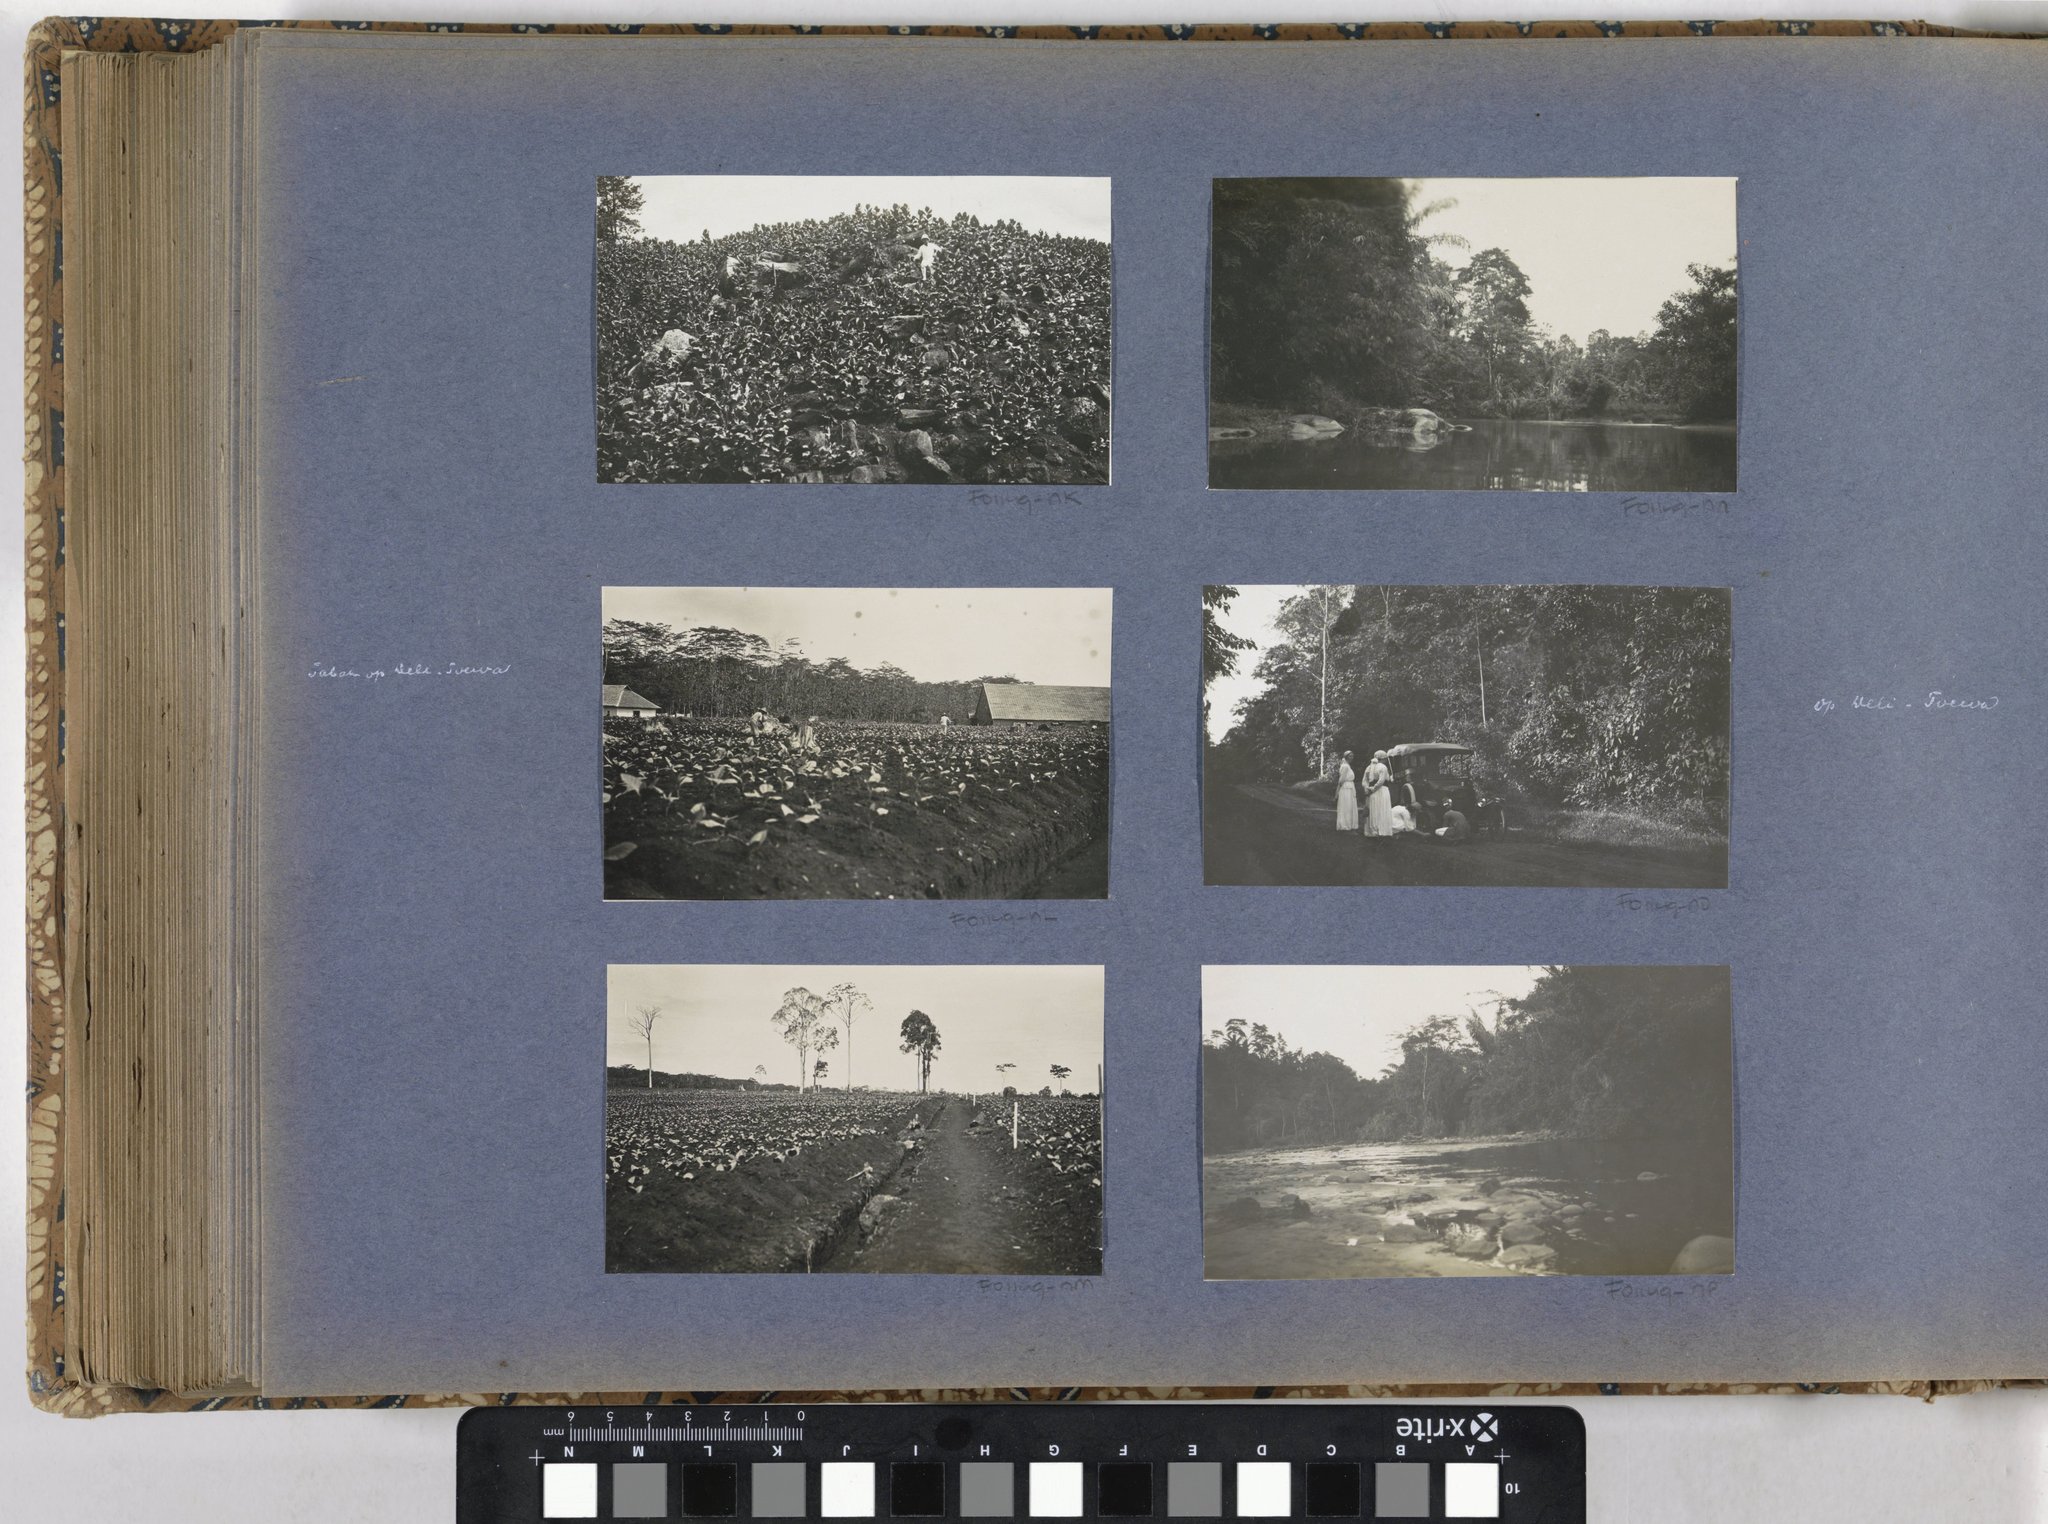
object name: album leaf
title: Water bij Deli-Toewa op Sumatra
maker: Anonymous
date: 1900-1920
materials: paper, photographic support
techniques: gelatin silver print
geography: sumatra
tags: river, sumatra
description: Onderdeel van reisalbum met foto's van bedrijvigheid en bezienswaardigheden op Sumatra en Java en van de reis naar en van Nederlands-Indië.